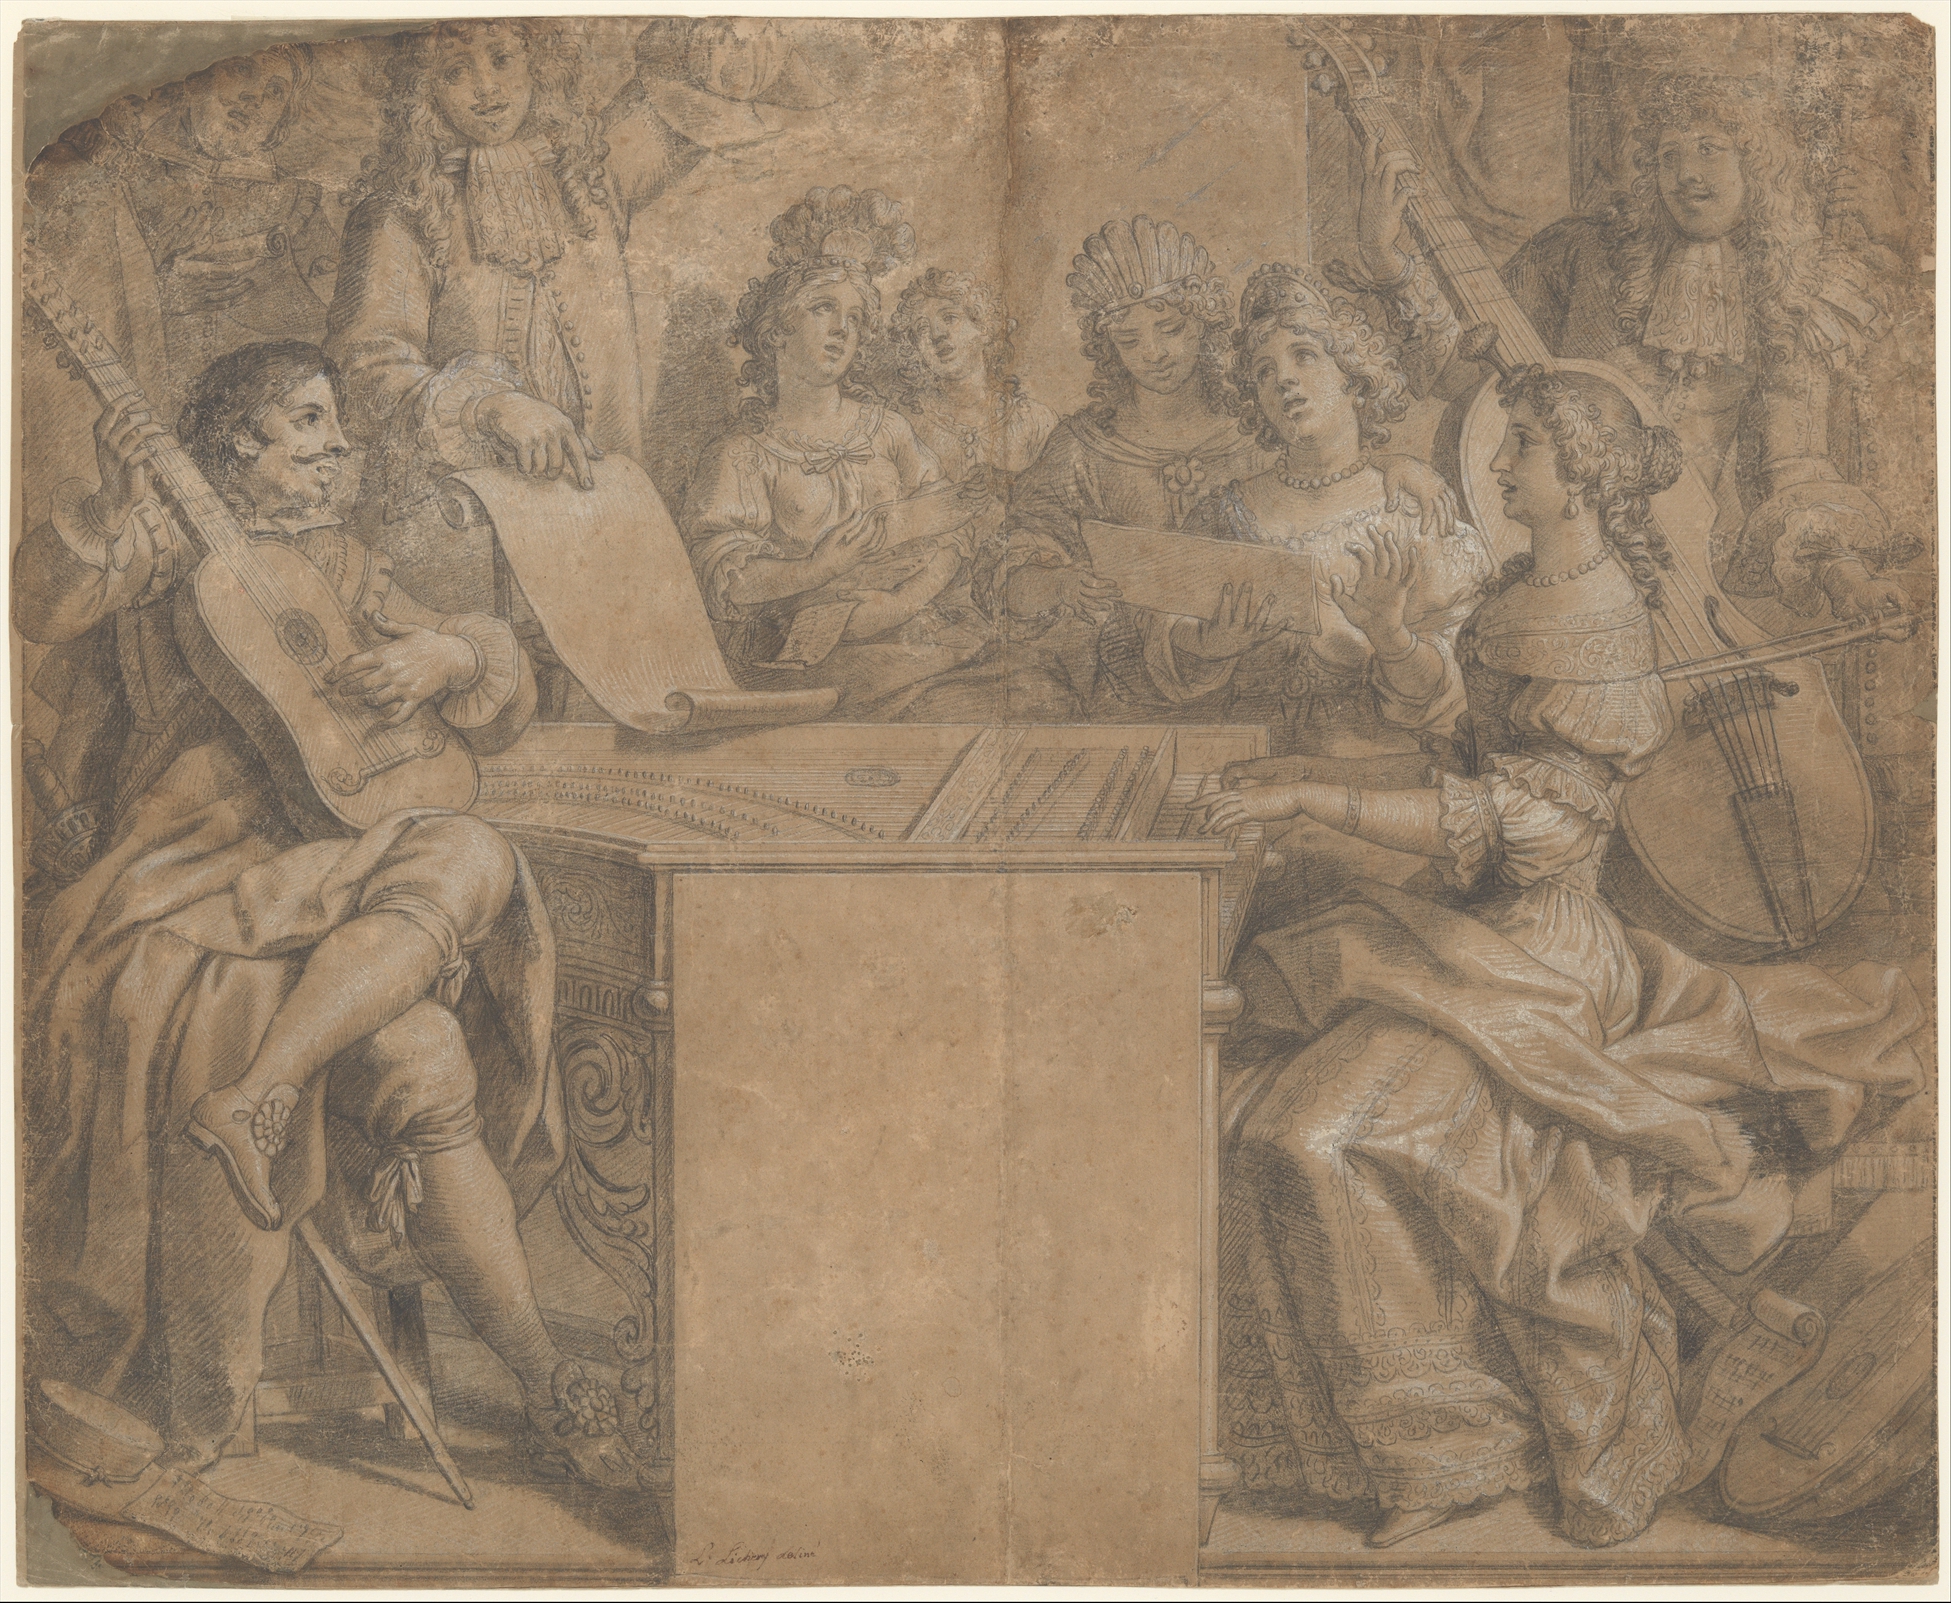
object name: drawing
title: A Concert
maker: louis licherie de beurie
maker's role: artist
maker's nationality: french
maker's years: 1629-1687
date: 1679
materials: chalk, paper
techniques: heightening, incising, transfer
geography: france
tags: men,women,concerts,guitars,violins